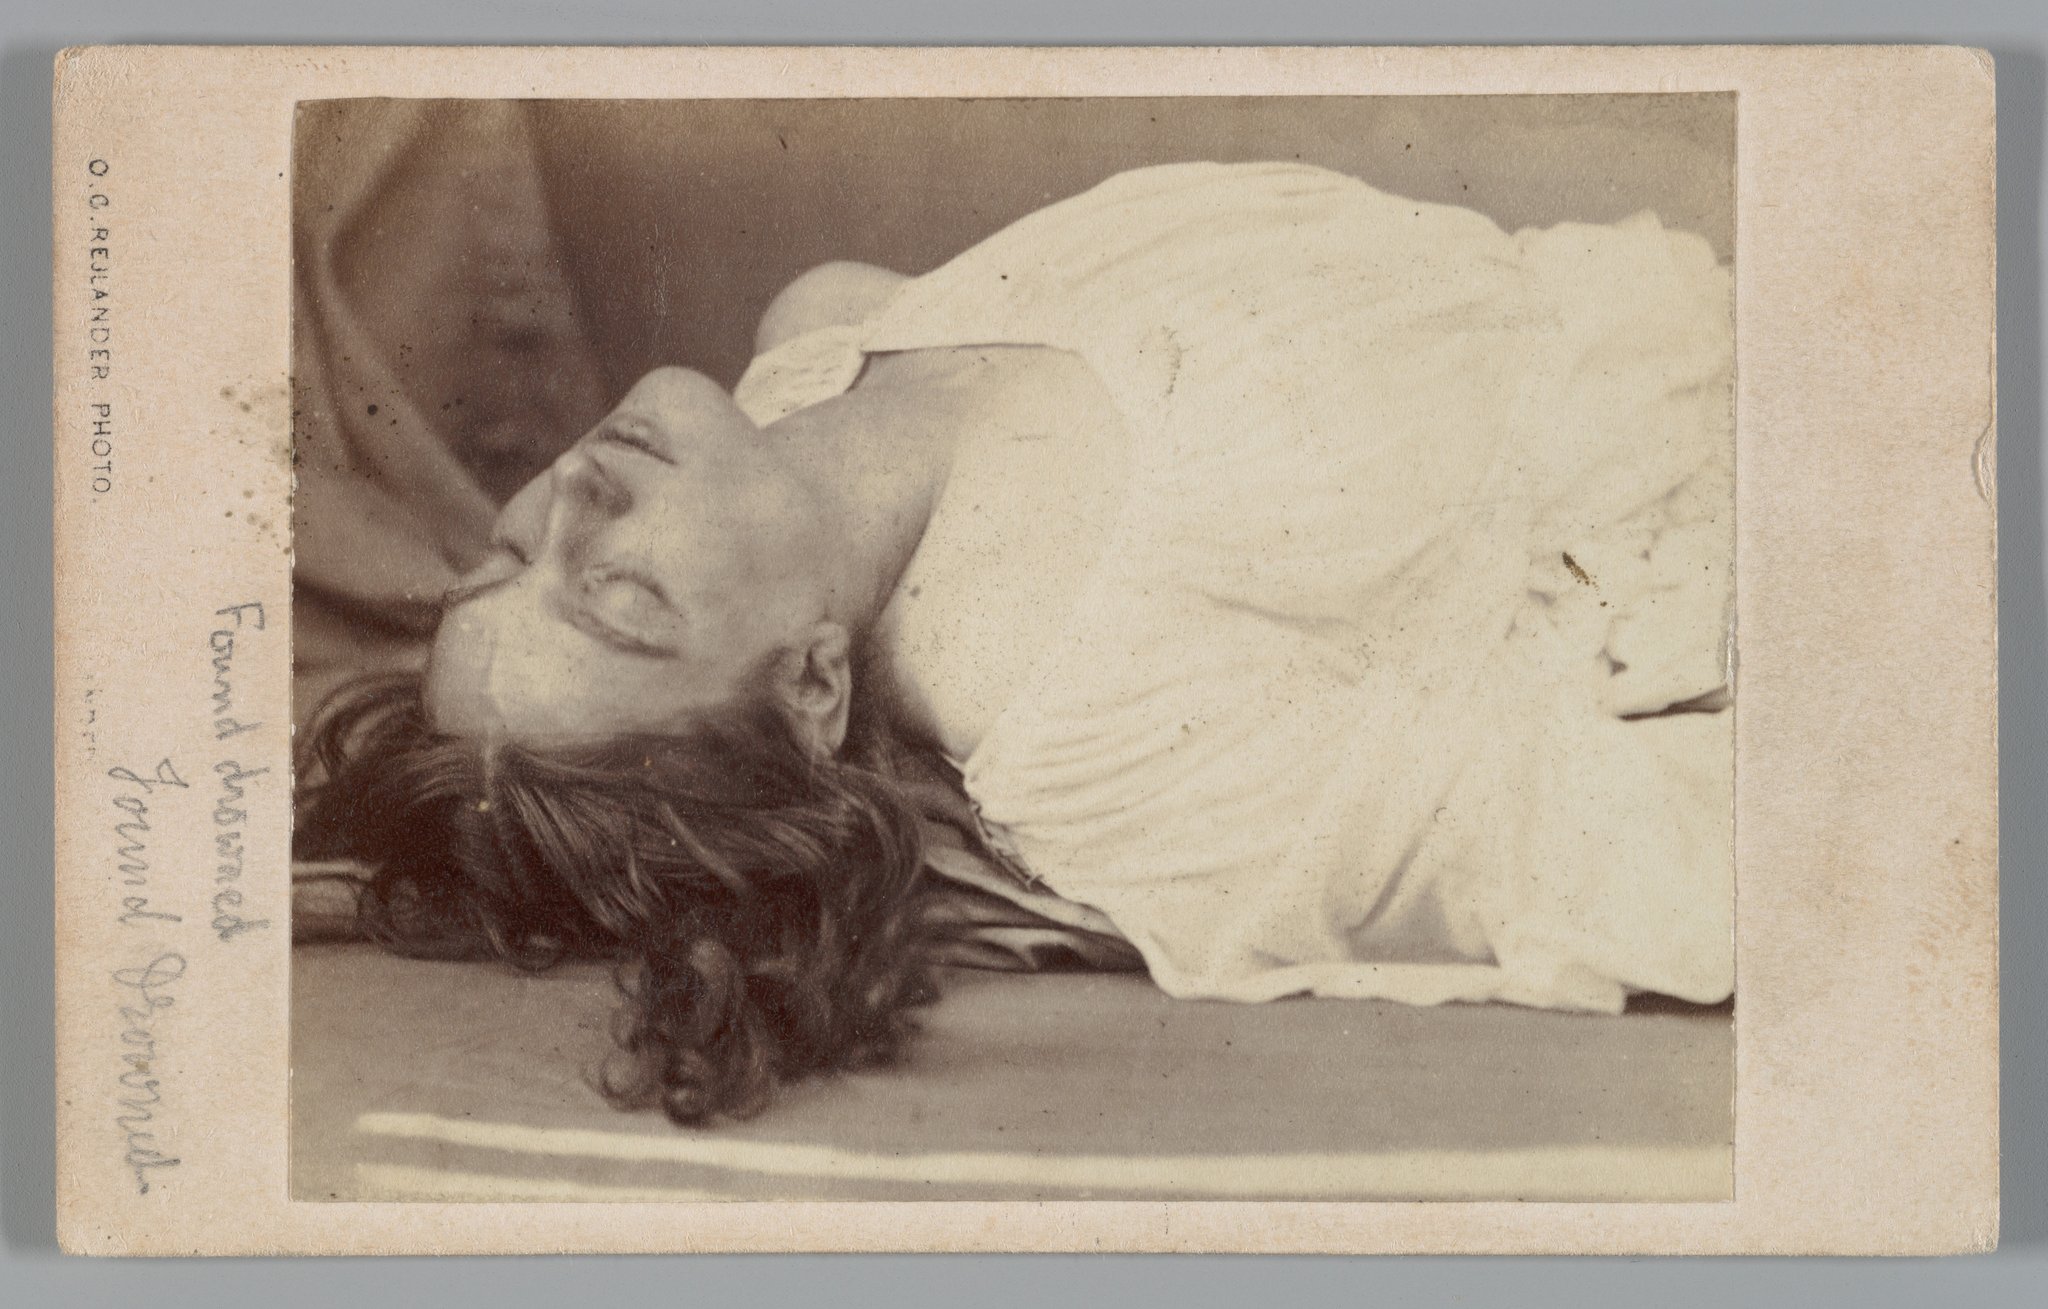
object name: carte de visite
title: Found Drowned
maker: oscar gustav rejlander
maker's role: artist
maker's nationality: british, born sweden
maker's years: 1813-1875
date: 1862-1869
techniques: albumen silver print